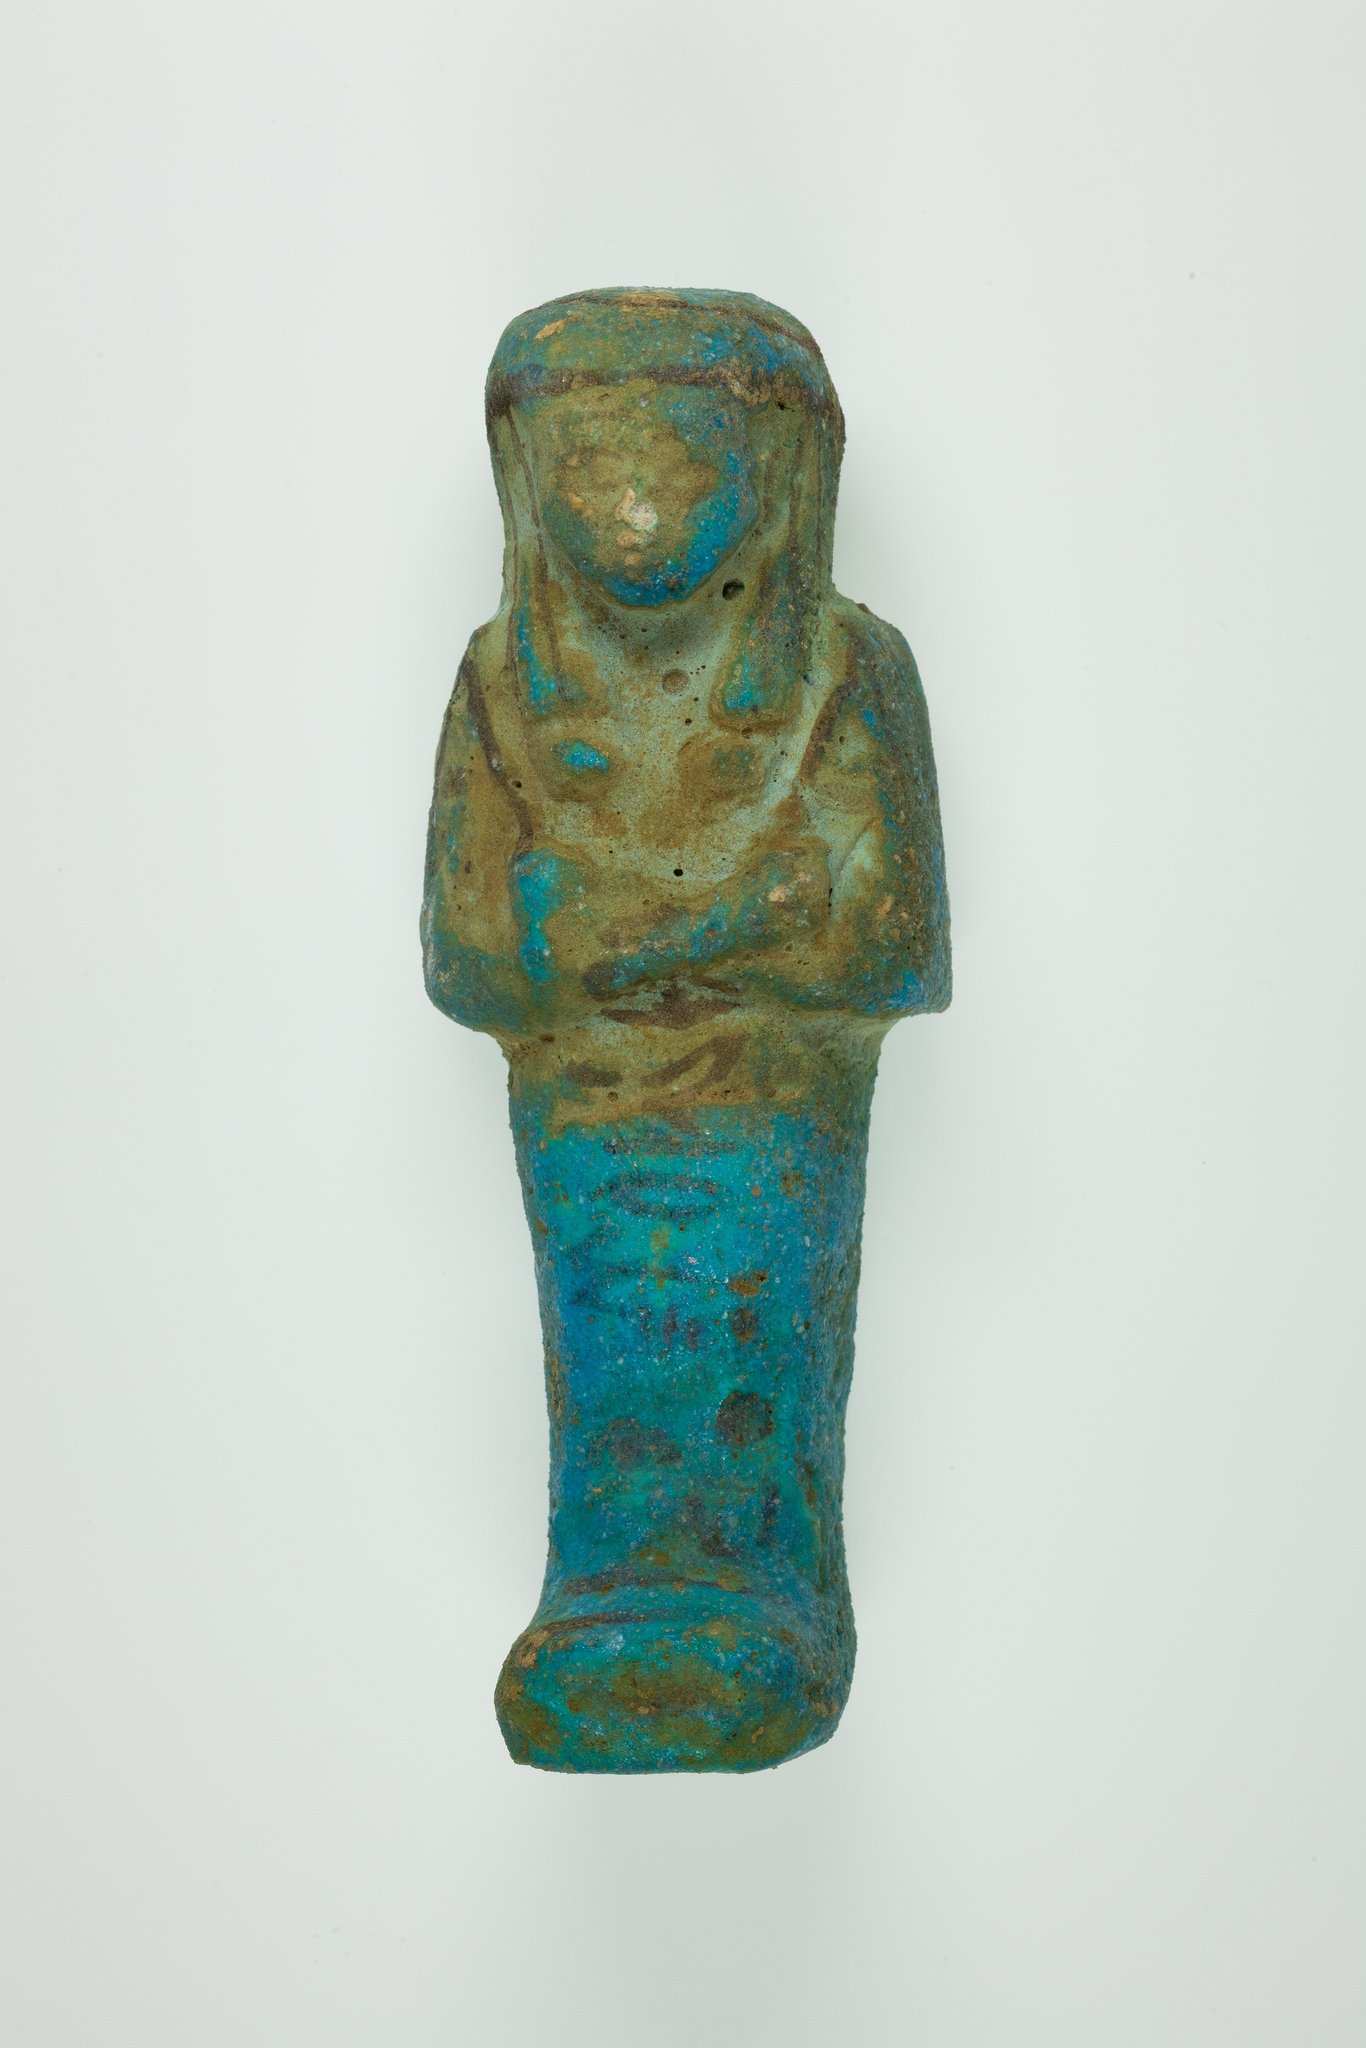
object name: worker shabti, henettawy c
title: Worker Shabti of Henettawy (C), Daughter of Isetemkheb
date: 990-970 BCE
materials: faience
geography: egypt